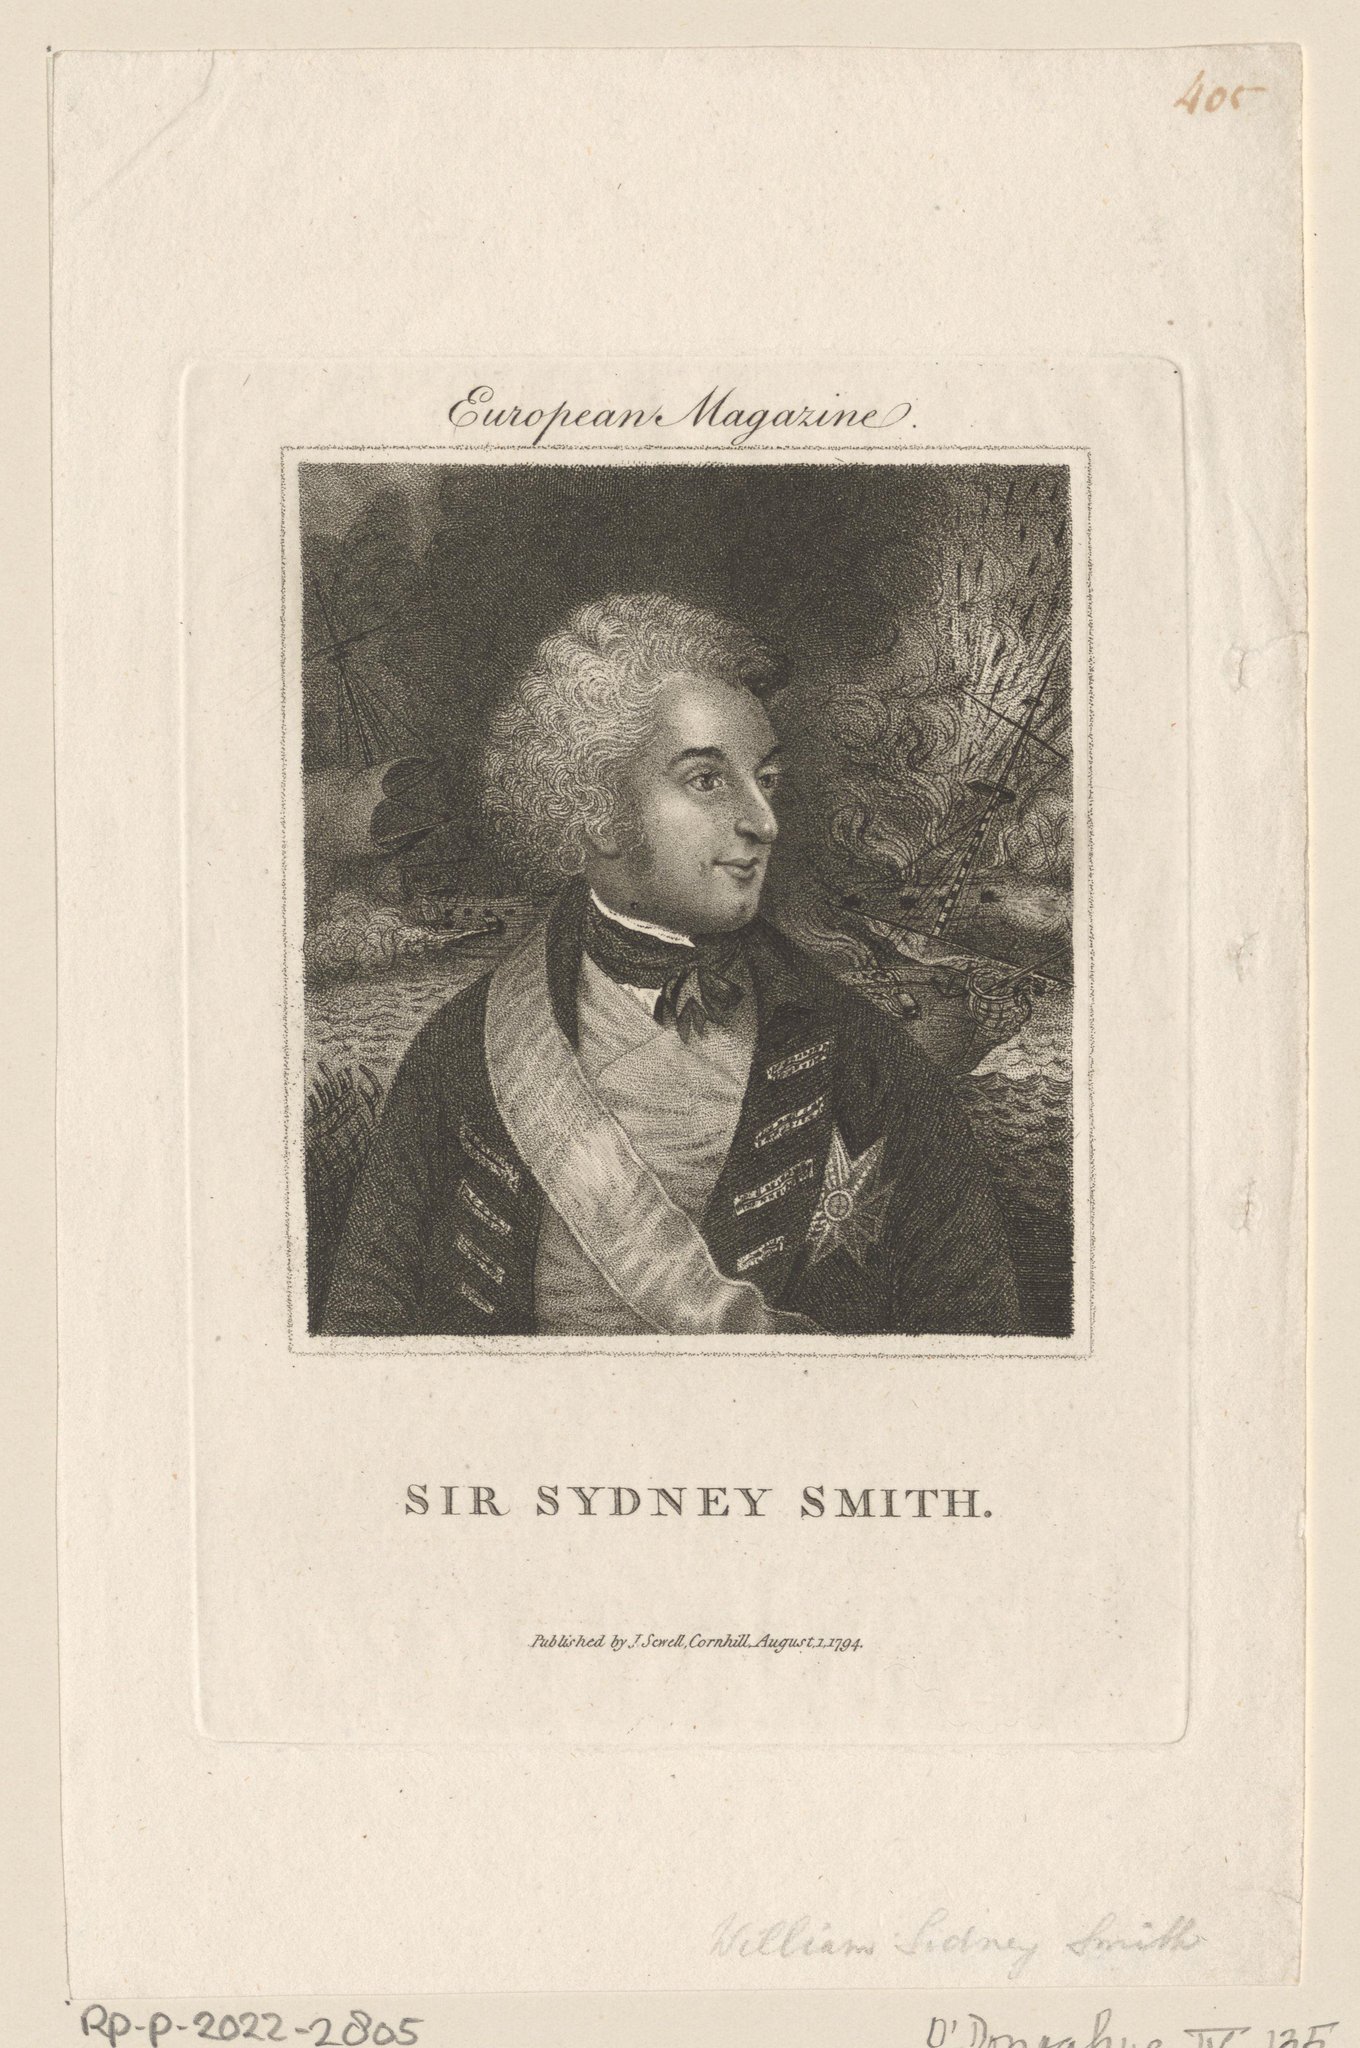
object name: print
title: Portret van Sidney Smith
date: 1794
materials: paper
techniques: etching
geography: london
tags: paris, designer, naval officer, sidney smith, historical persons, commander-in-chief, admiral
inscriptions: number: ‘405’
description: Prent waarschijnlijk uit: European Magazine (1794), augustus 1794.